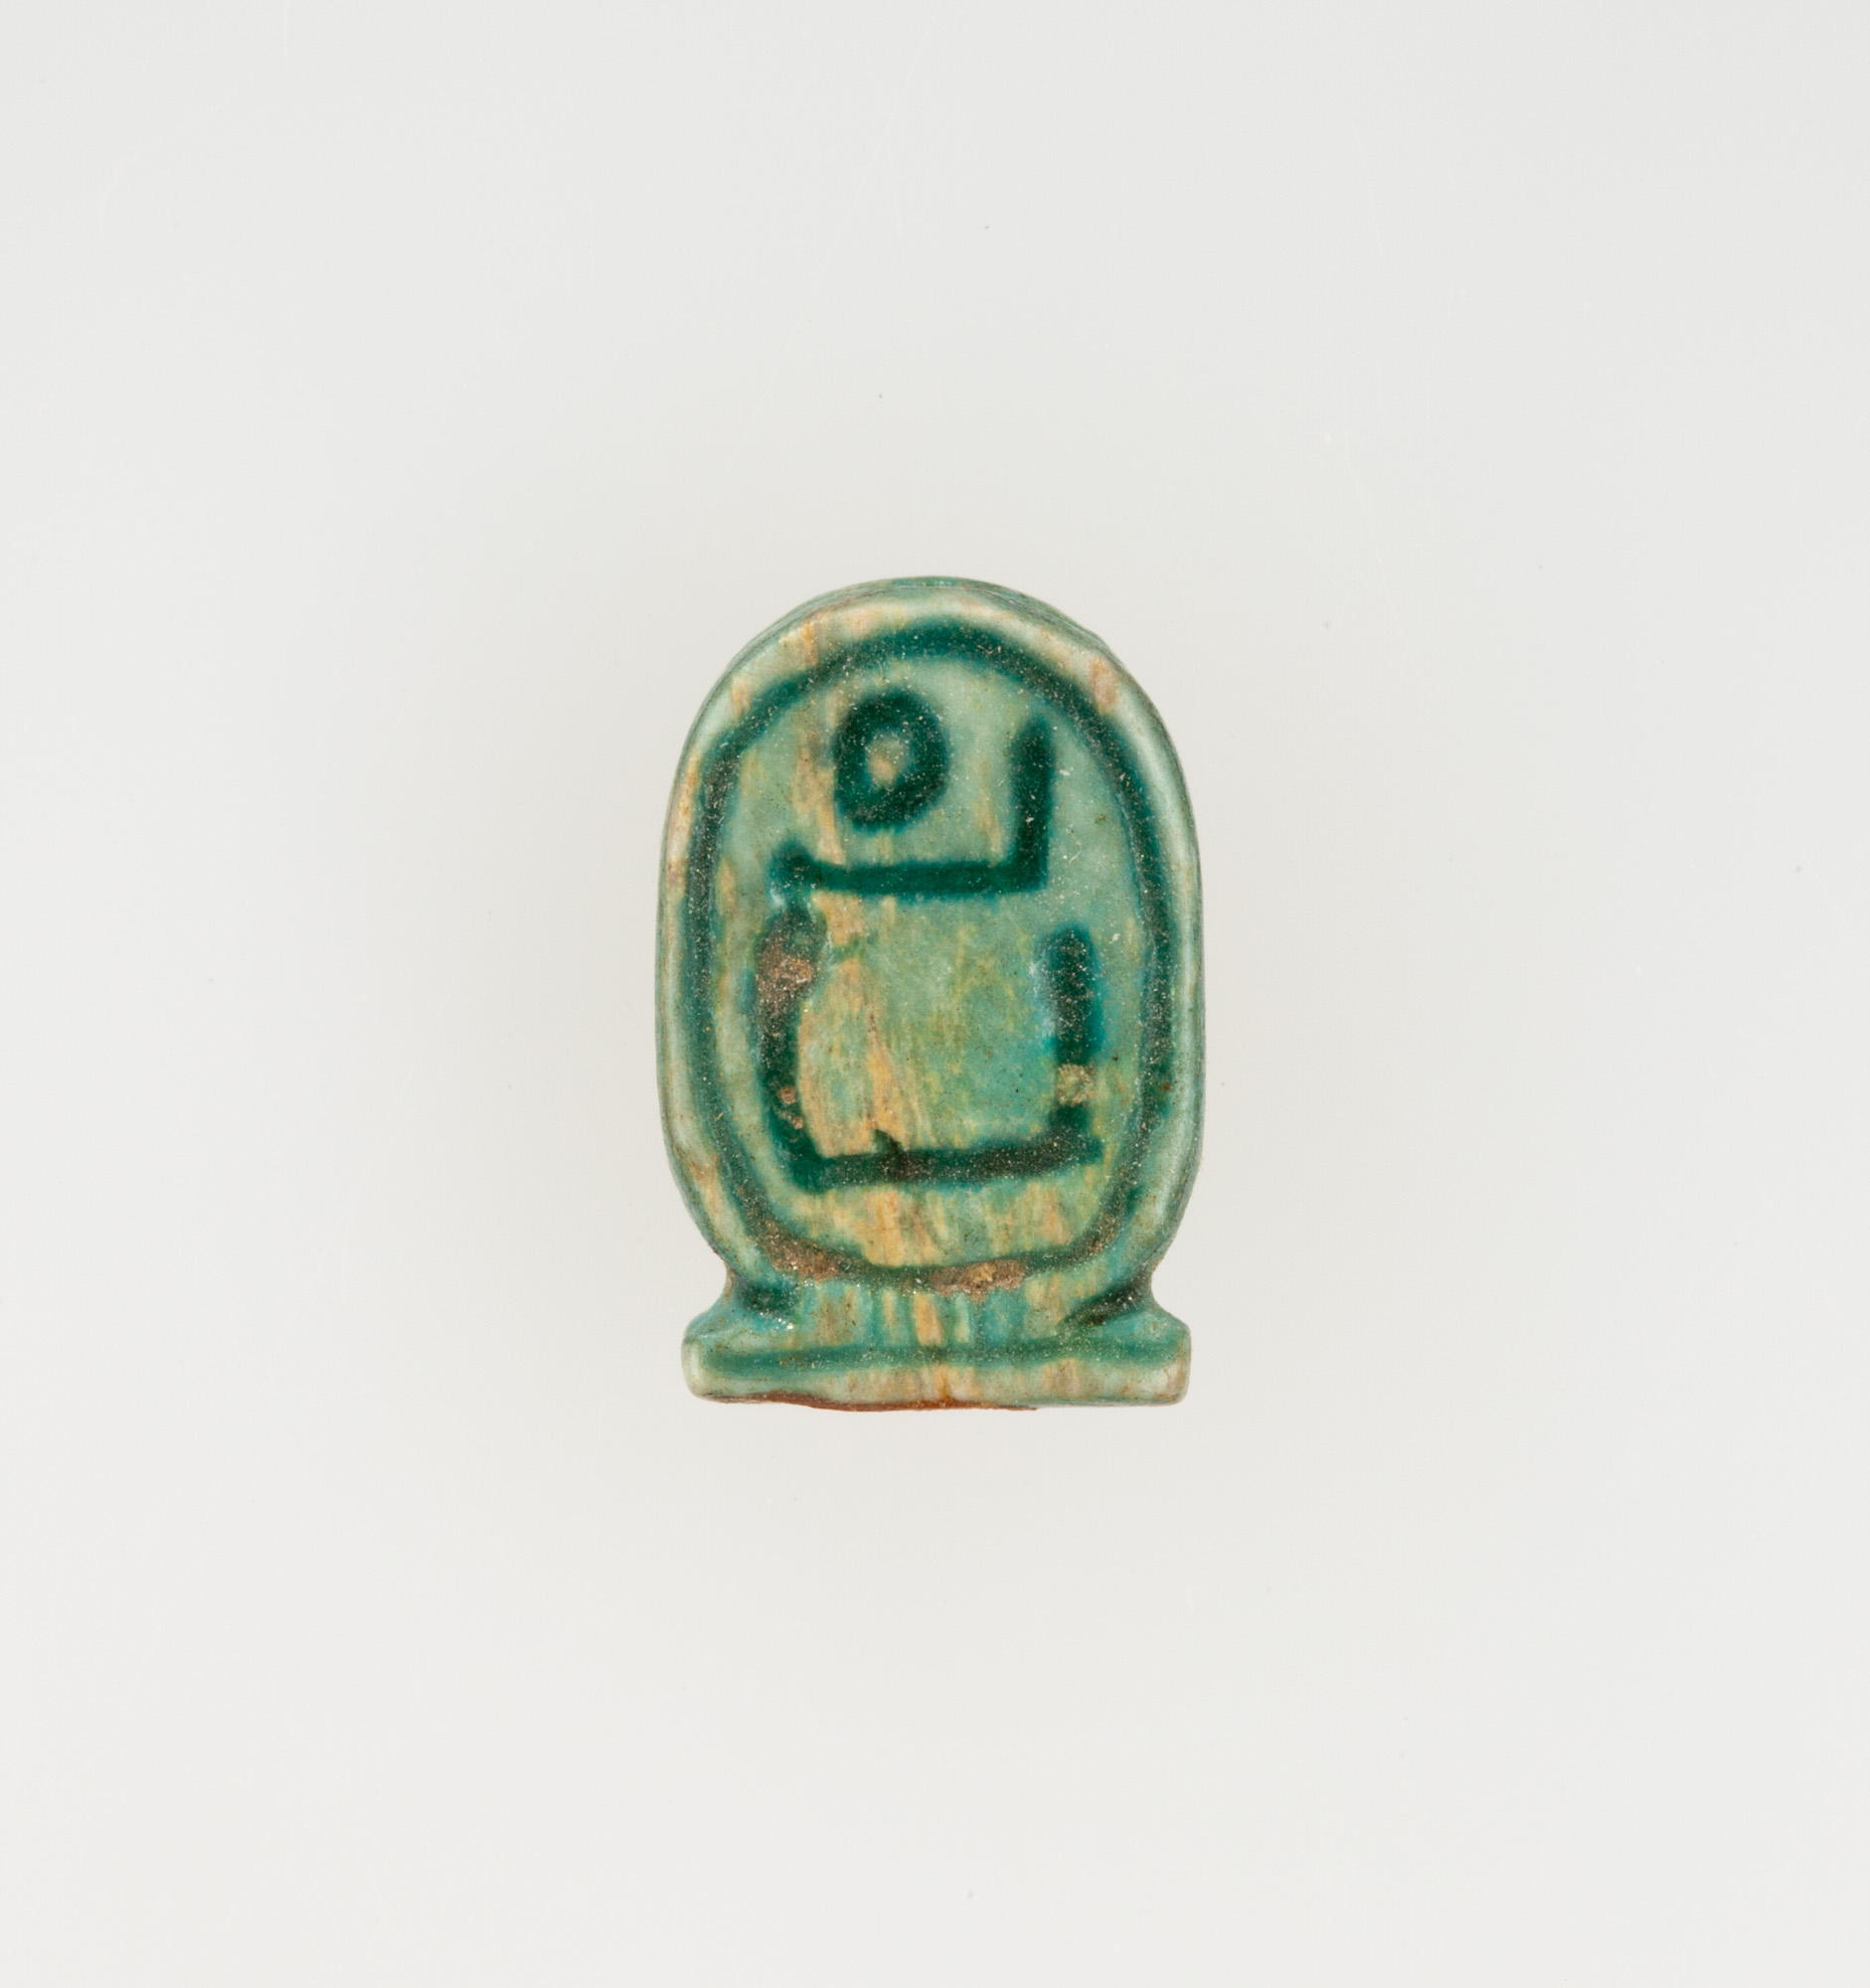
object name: plaque, amenhotep i, djeserkare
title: Plaque Inscribed with the Throne Name of Amenhotep I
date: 1525-1504 BCE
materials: stone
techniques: glazing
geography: egypt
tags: hieroglyphs